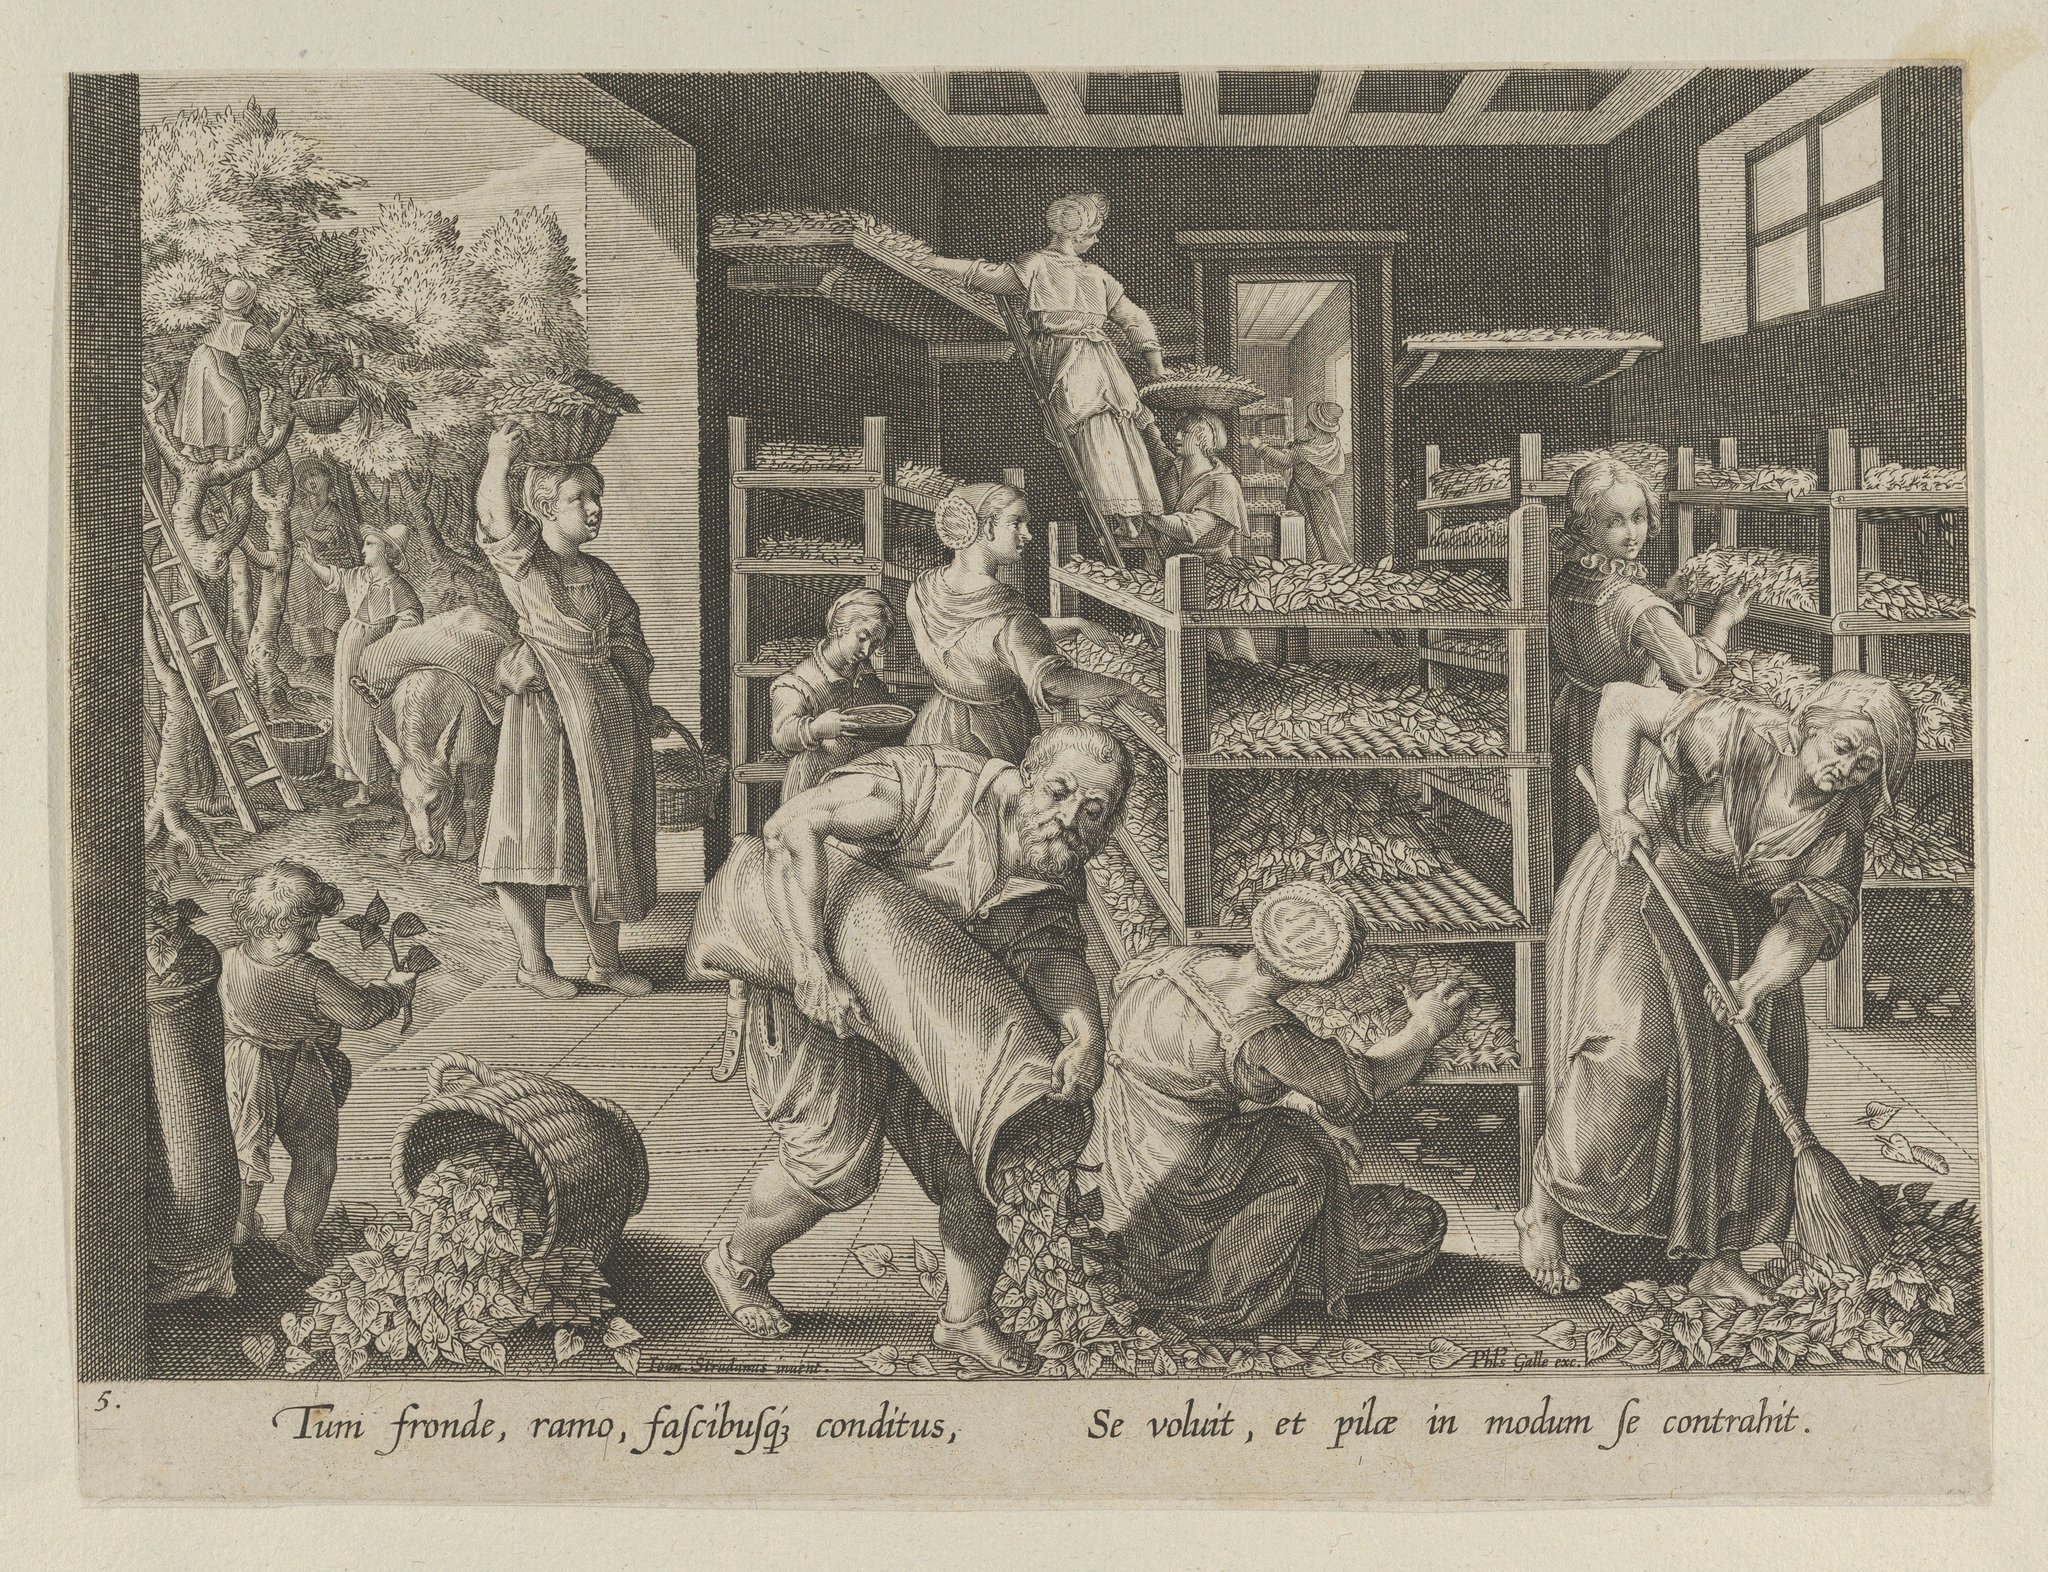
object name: print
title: The Gathering of Mulberry Leaves and the Feeding of the Silkworms, Plate 5 from "The Introduction of the Silkworm" [Vermis Sericus]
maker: karel van mallery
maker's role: artist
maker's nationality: netherlandish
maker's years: 1571-1645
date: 1595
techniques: engraving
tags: men,women,leaves,working